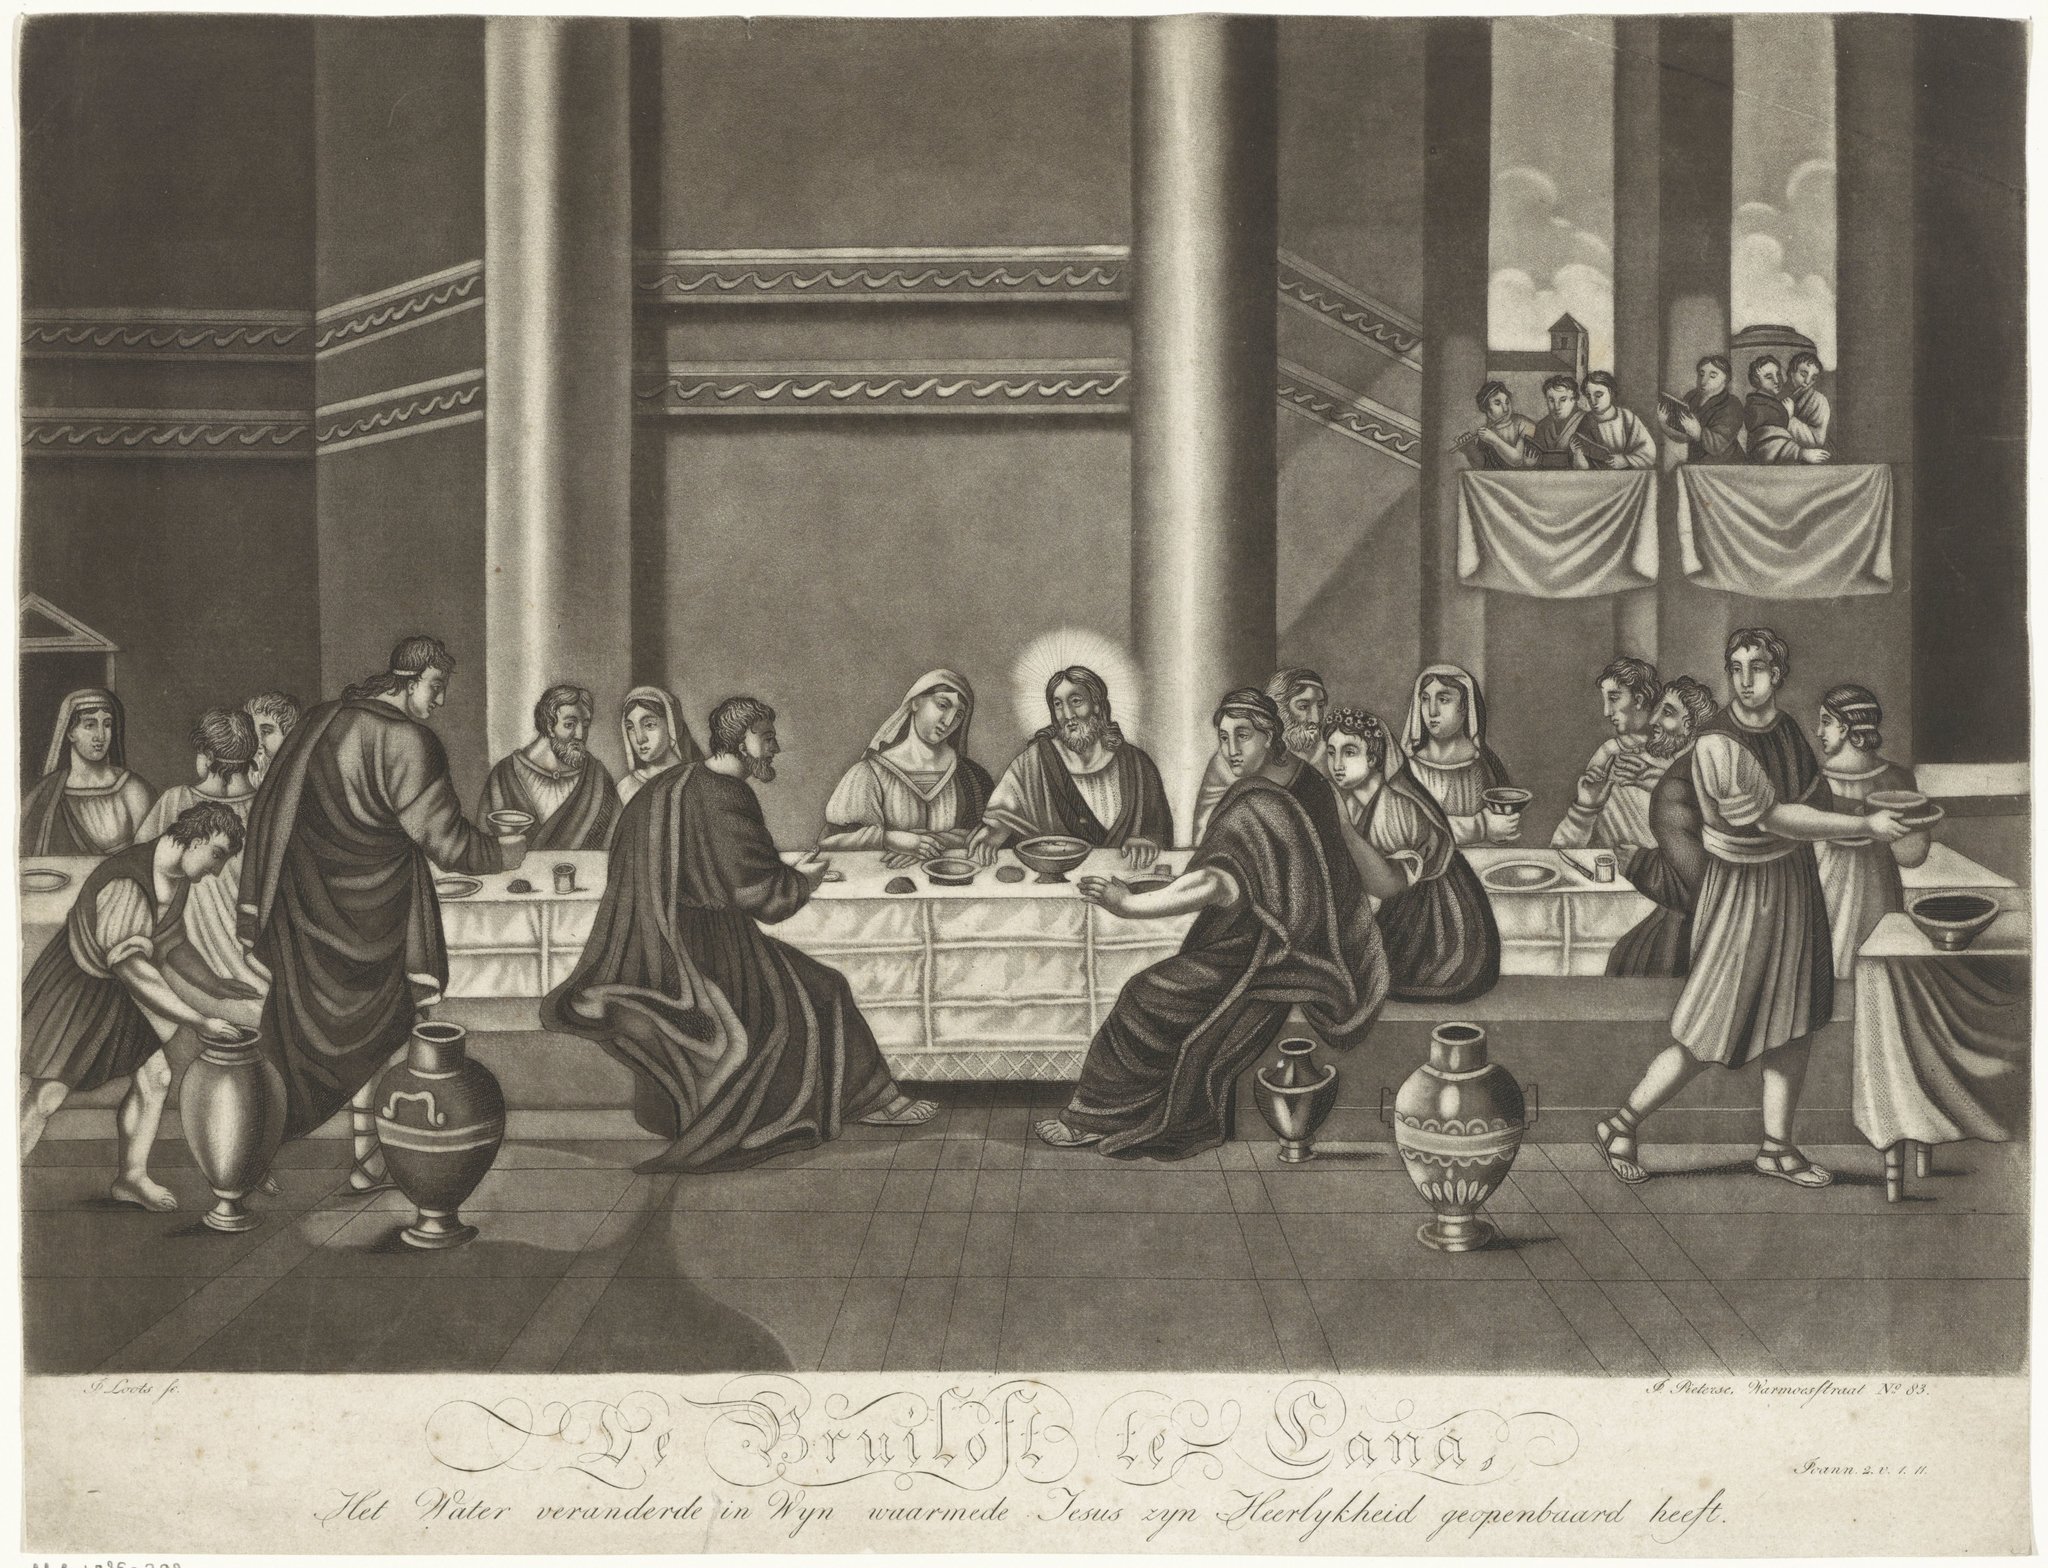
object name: print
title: De bruiloft te Cana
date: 1800-1840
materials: paper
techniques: engraving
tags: christ orders (six) jars to be filled with water ~ marriage-feast at cana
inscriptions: collector's mark: Lugt 2760, collector's mark: Lugt 2228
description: Op de bruiloft van Kana beveelt Christus zes kruiken met water te vullen. Vervolgens verandert hij het water in wijn (Johannes 2:1-11).